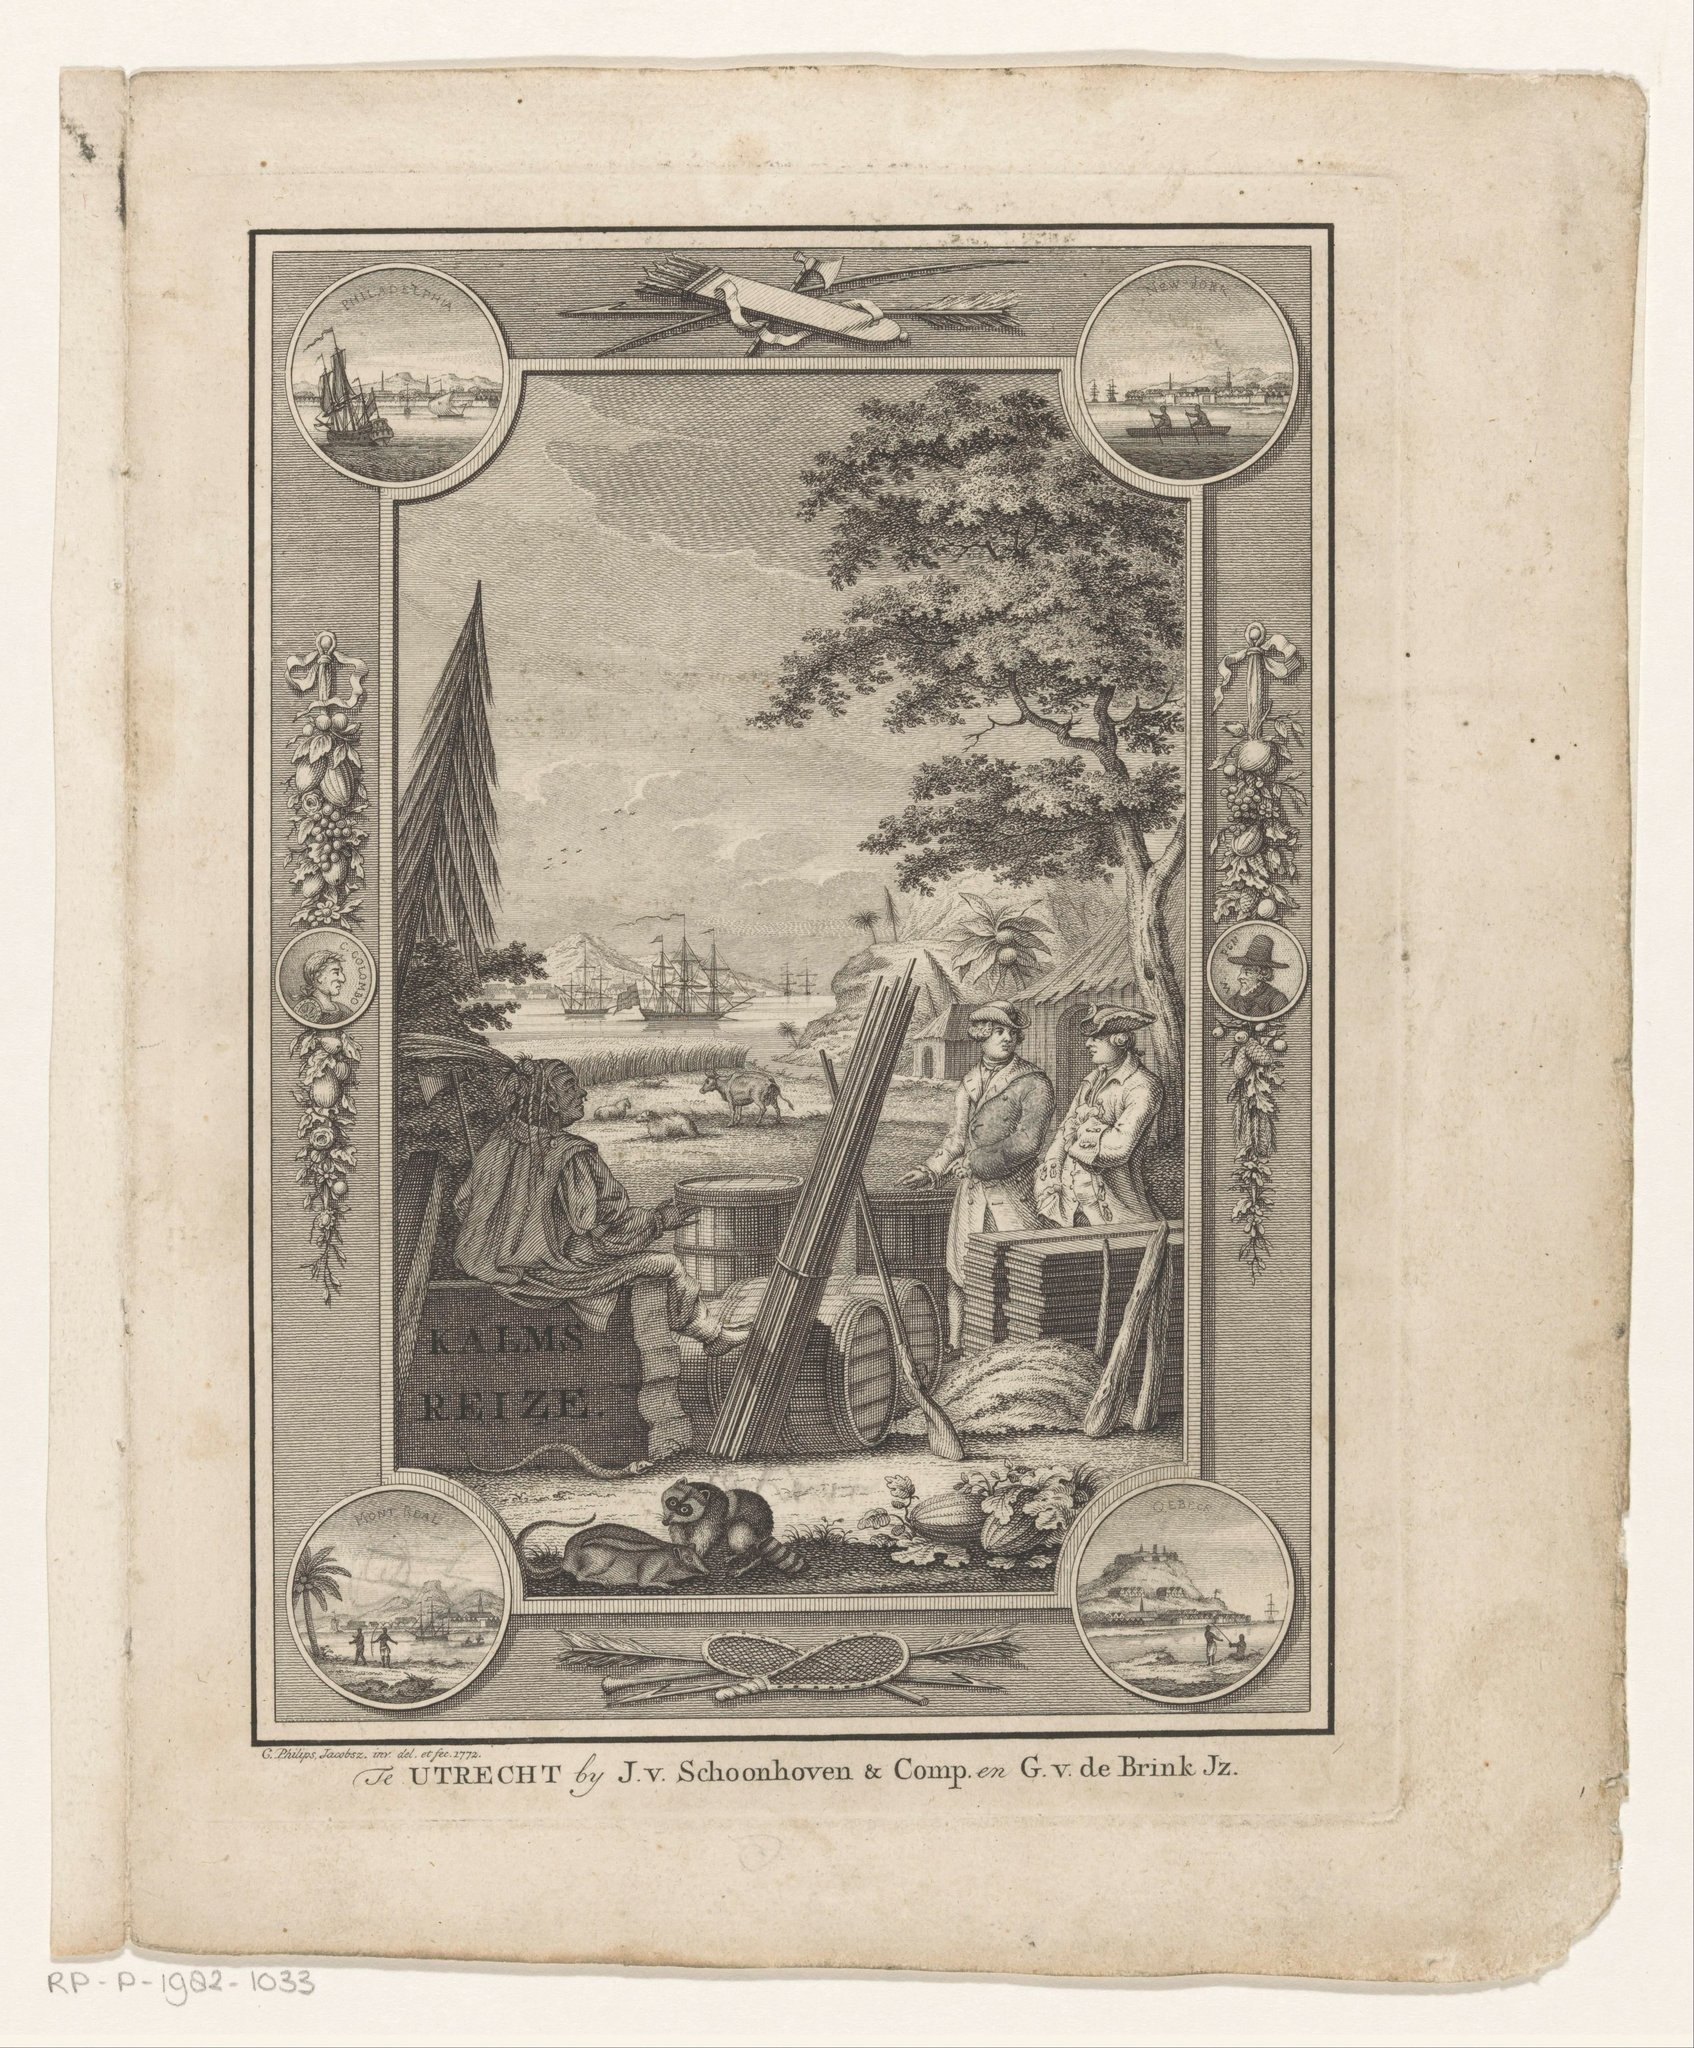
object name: titelblad, titelpagina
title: Ontmoeting tussen twee Europeanen en een oorspronkelijke bewoner van Noord-Amerika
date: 1772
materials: paper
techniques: engraving, etching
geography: utrecht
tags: indigenous peoples of north america, exploration, expedition, voyage of discovery, new york (city), québec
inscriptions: collector's mark: Lugt 2228, collector's mark: Lugt 2760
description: Landschap in Noord-Amerika met een ontmoeting tussen twee Europese ontdekkingsreizigers en een oorspronkelijke bewoner van Noord-Amerika. Op de achtergrond de schepen waarmee de reizigers zijn aangekomen. De voorstelling is gevat in een omlijsting met zes medaillons waarin: een gezicht op Philadelphia, New York, Québec, Montréal en de portretten van Christoffel Columbus en William Penn.